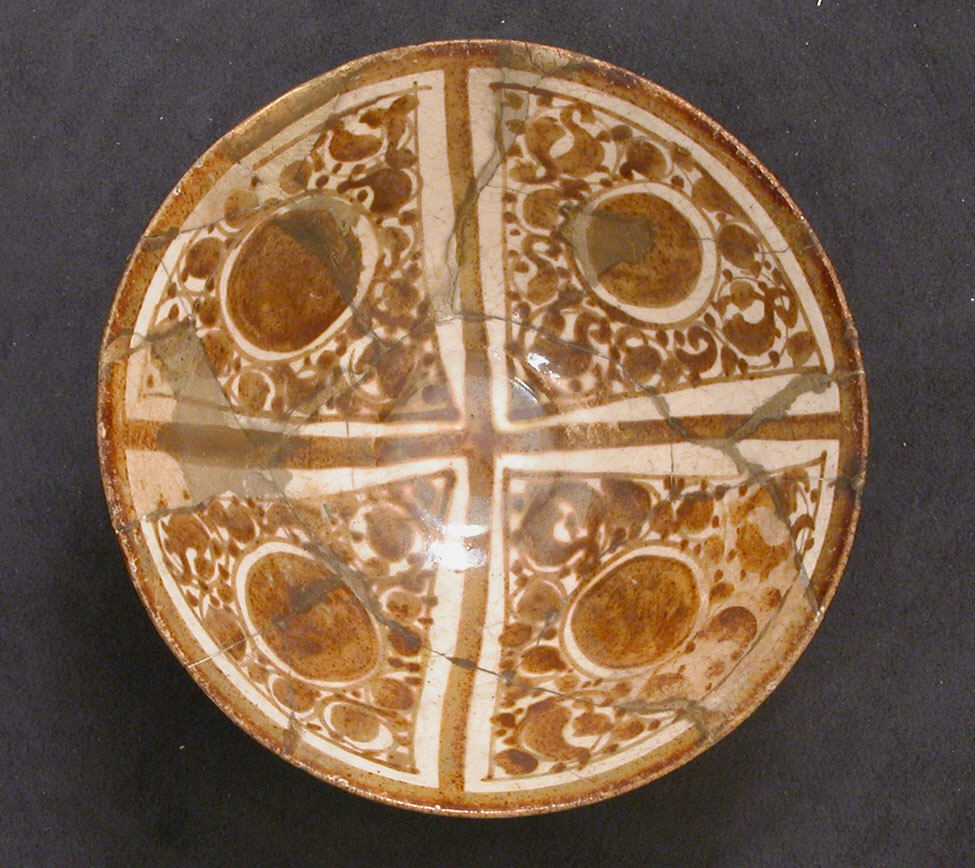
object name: bowl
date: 1101-1200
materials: stonepaste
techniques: luster painting, overglaze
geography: iran